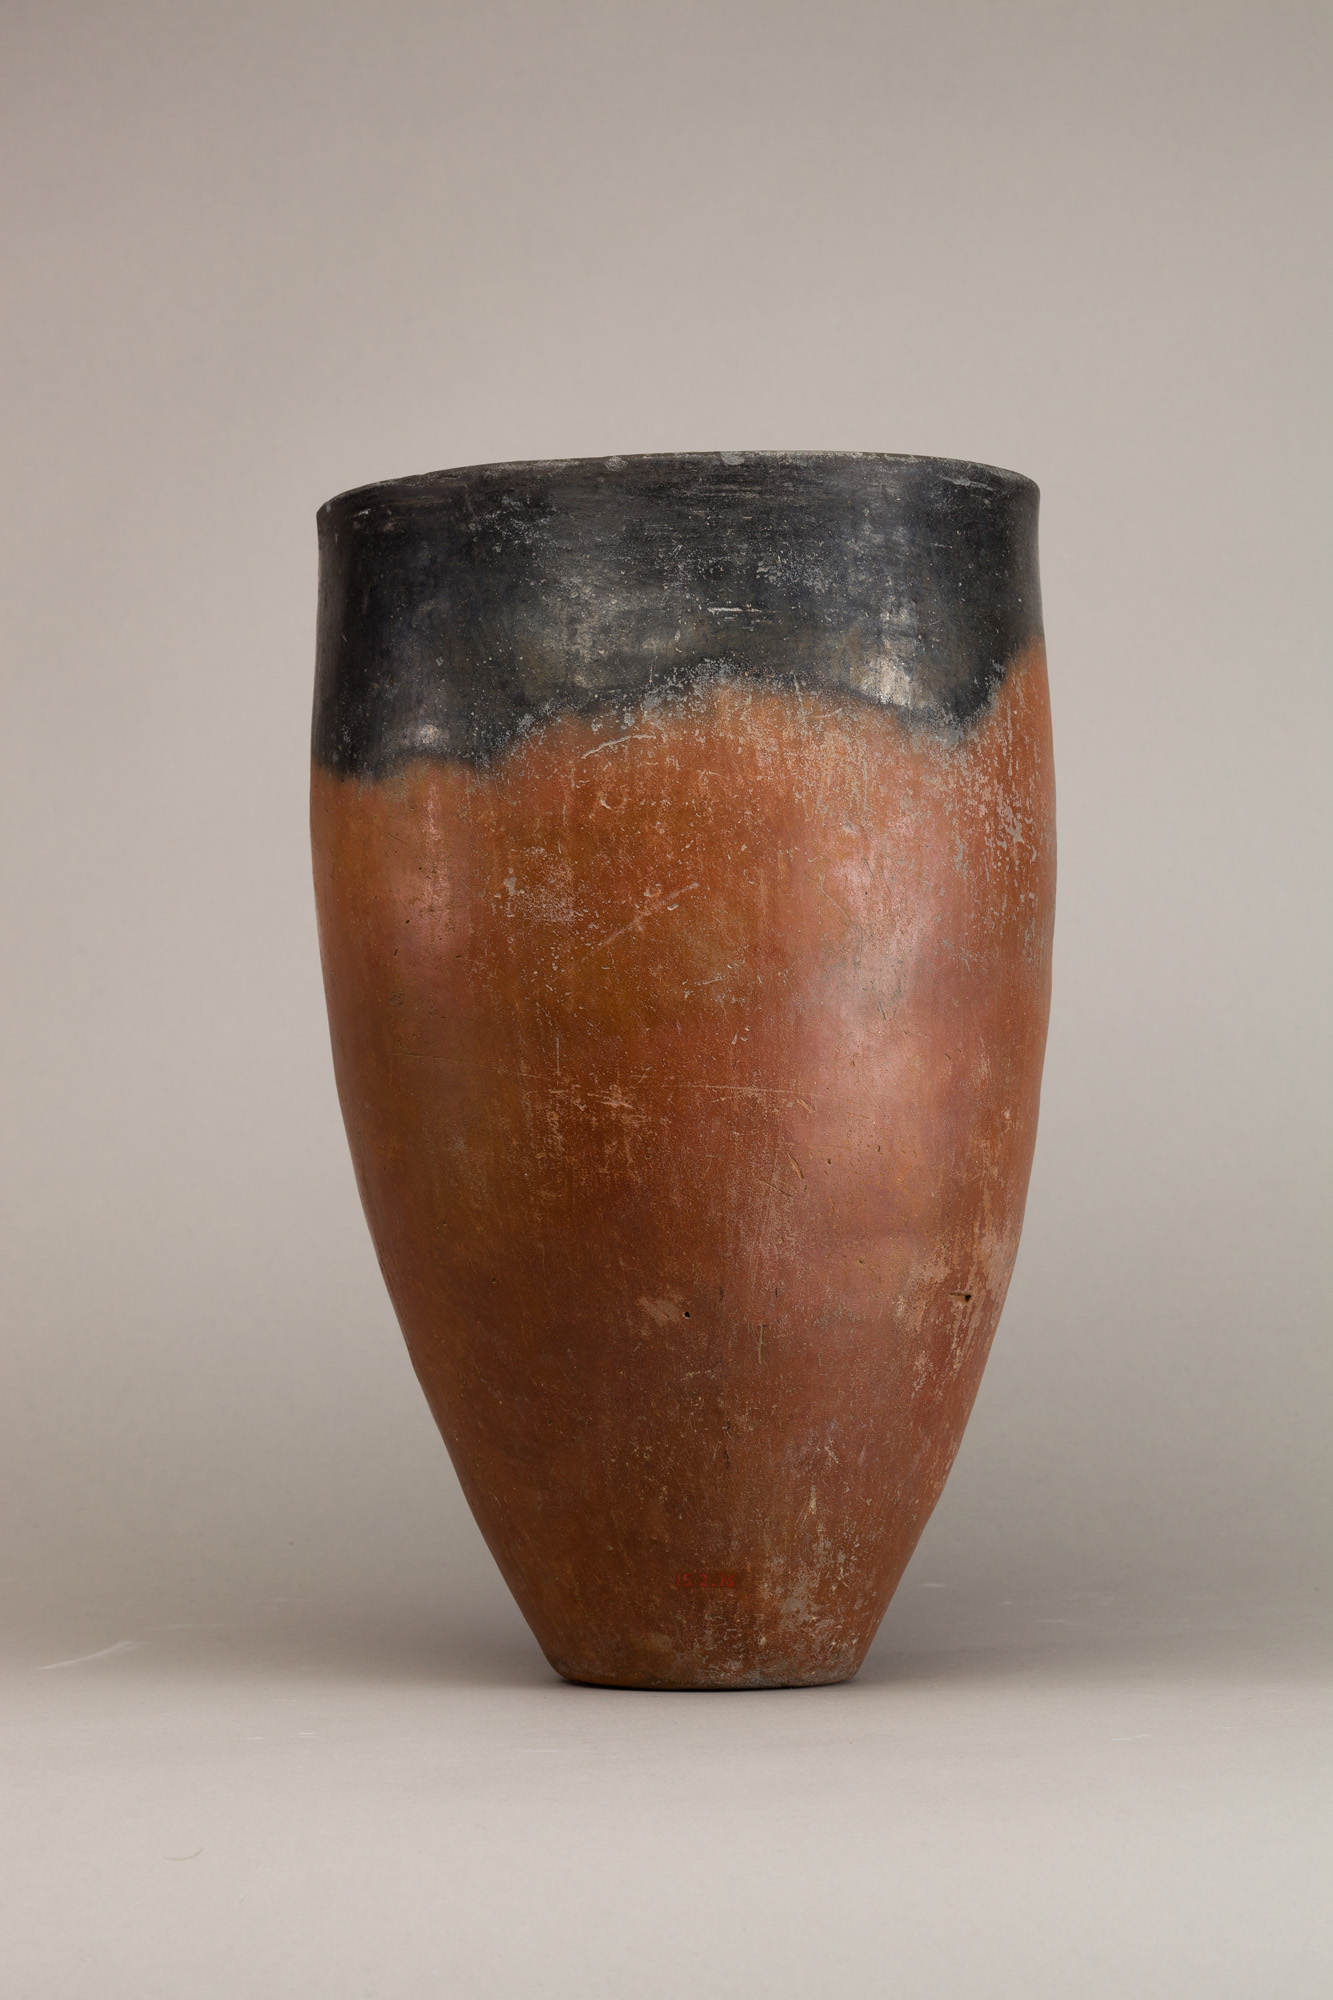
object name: beaker, black topped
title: Black-topped Red Ware Beaker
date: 3850-2960 BCE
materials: pottery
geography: egypt